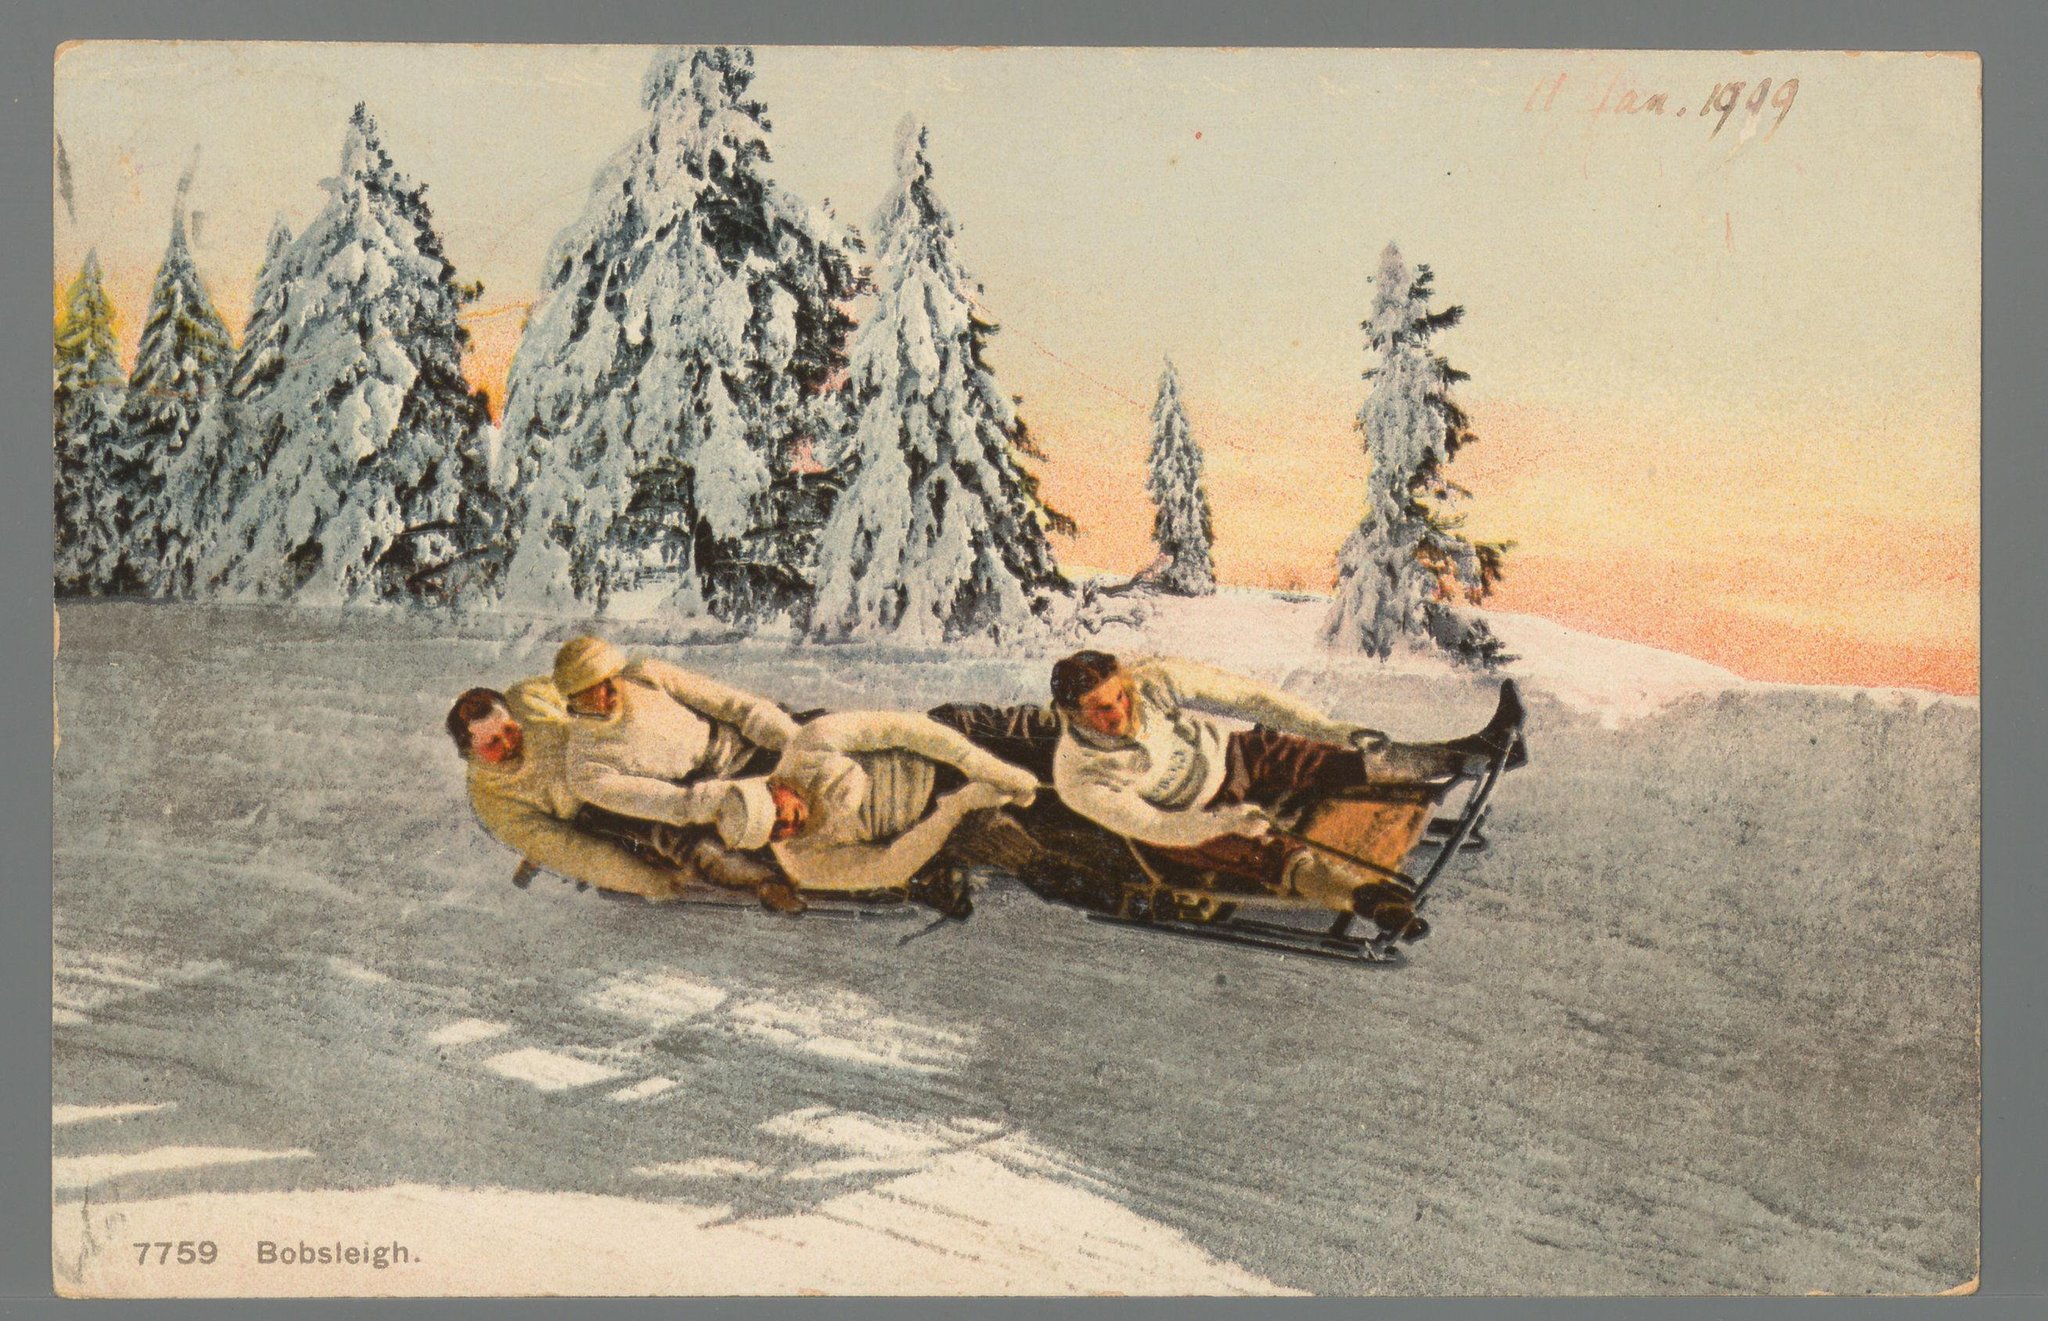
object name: photomechanical print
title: Bobsleigh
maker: Anonymous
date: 1905-1909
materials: cardboard, photographic process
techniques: writing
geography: switzerland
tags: snow, small sleigh (winter sports), switzerland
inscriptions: postage stamp